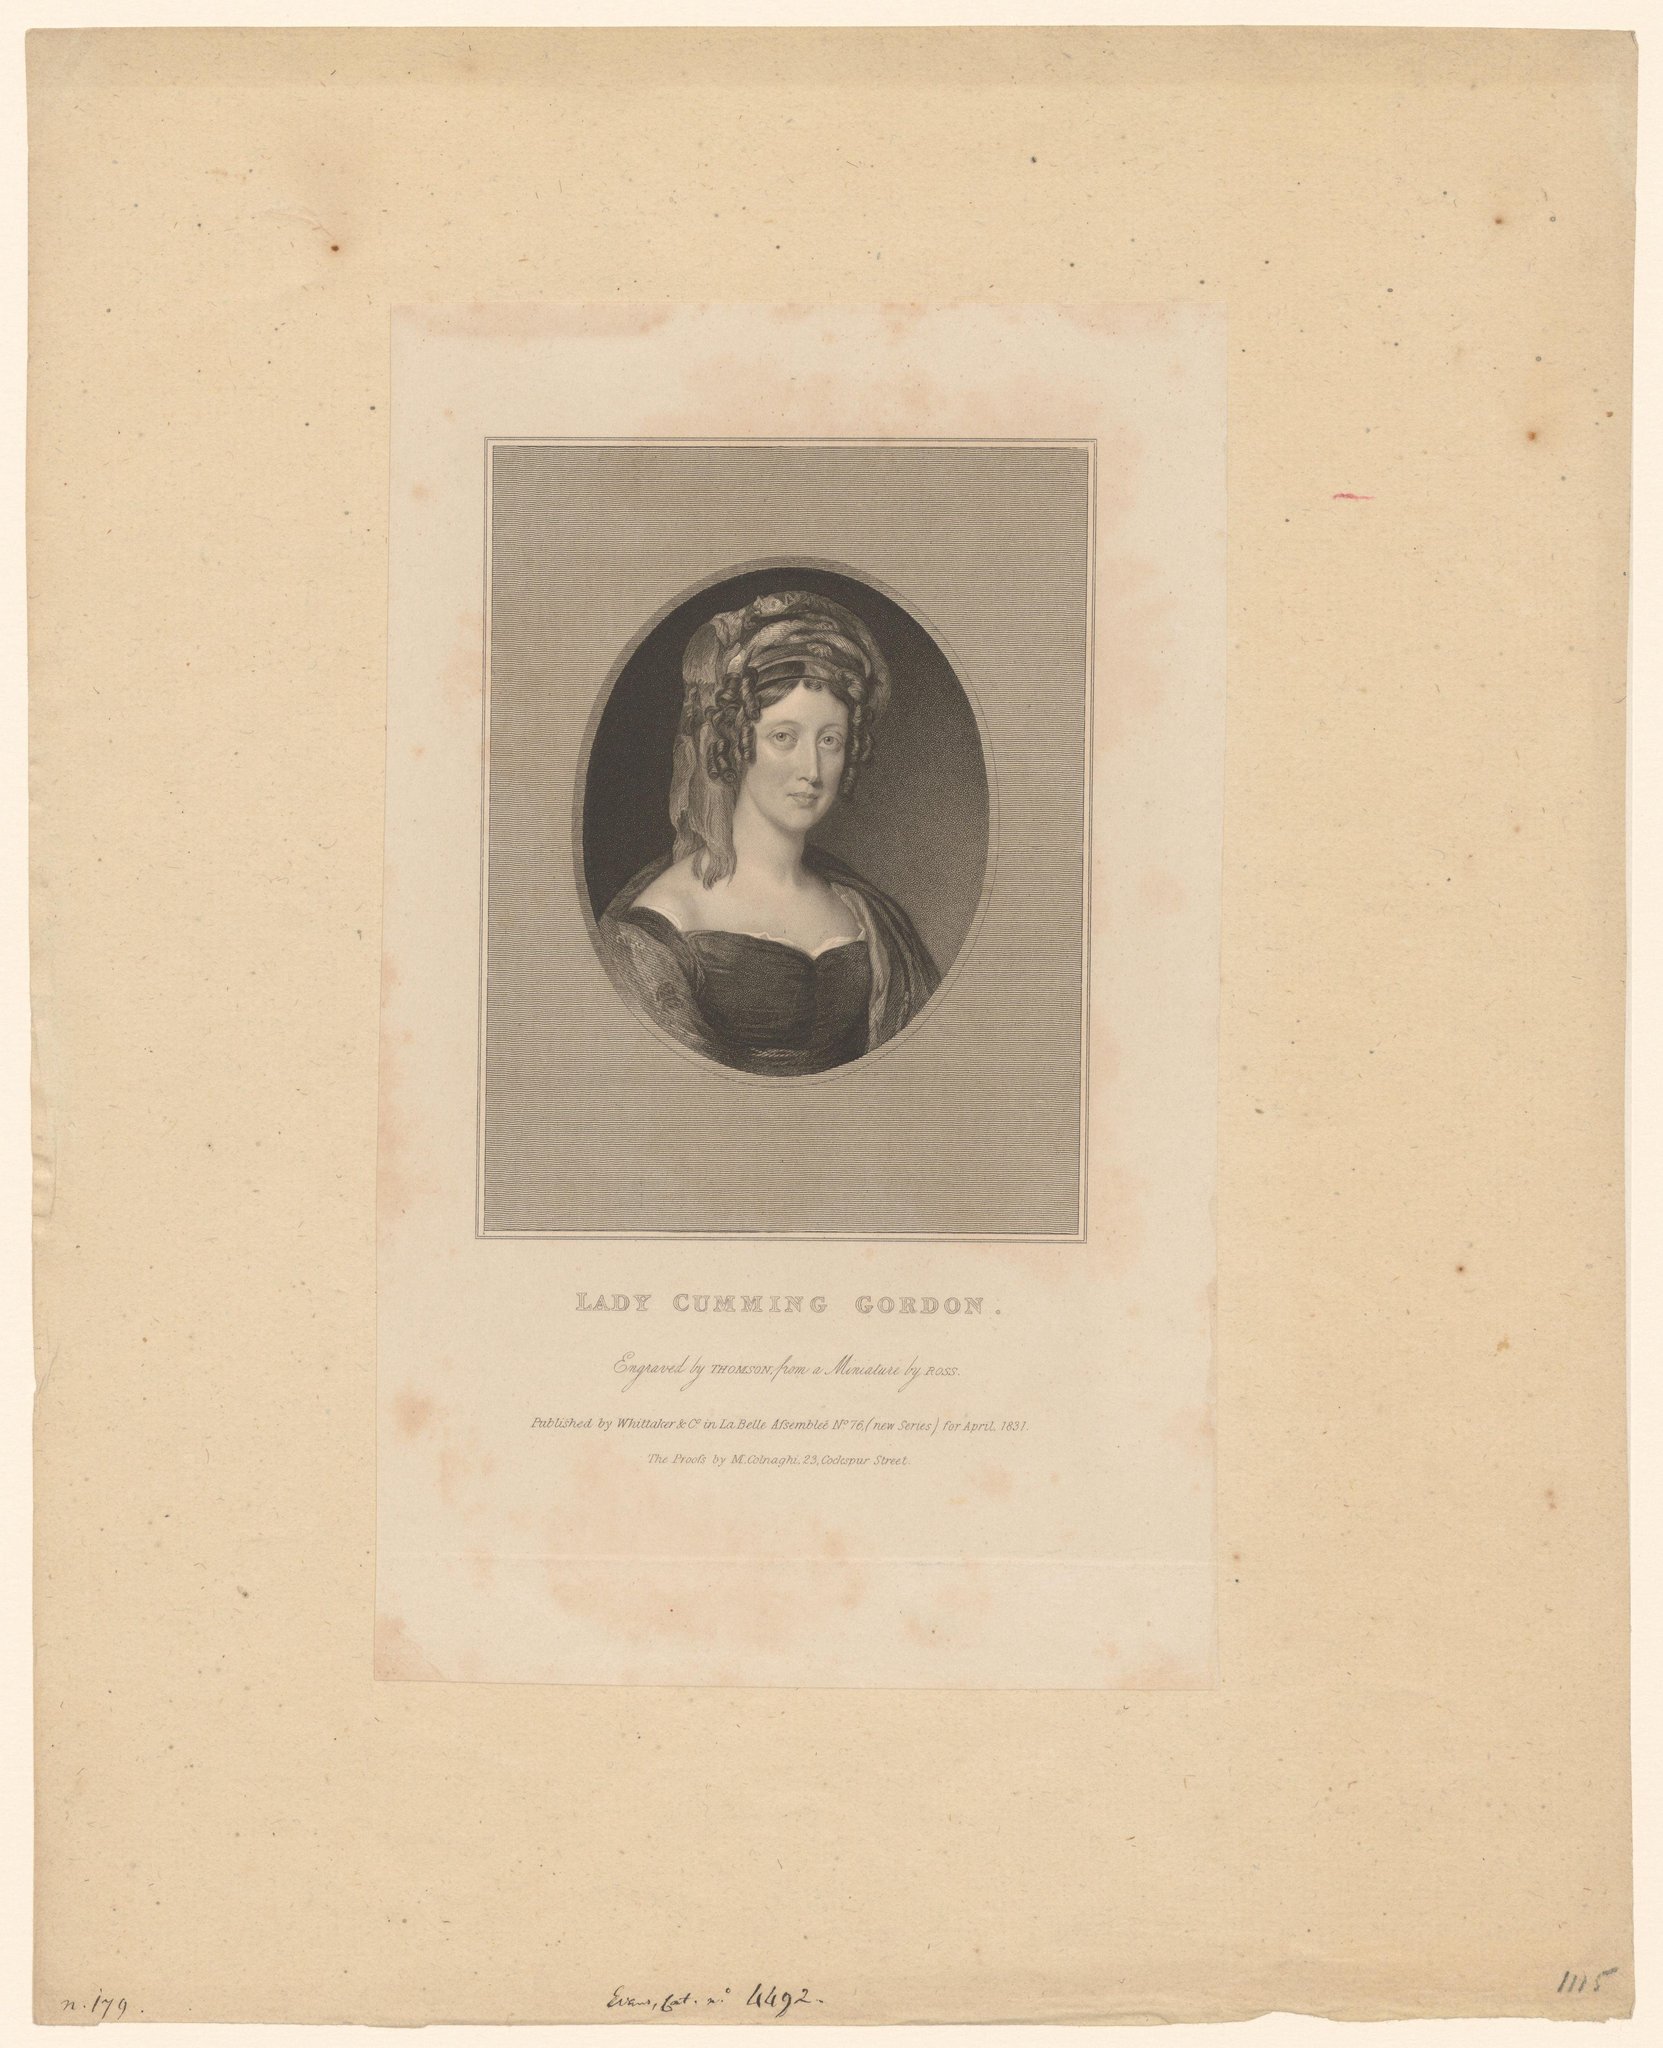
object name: print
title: Lady Cumming Gordon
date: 1804-1831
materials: paper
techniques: etching, engraving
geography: london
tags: historical persons, geology (+ portrait of scholar, scientist)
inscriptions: collector's mark: Lugt 2228